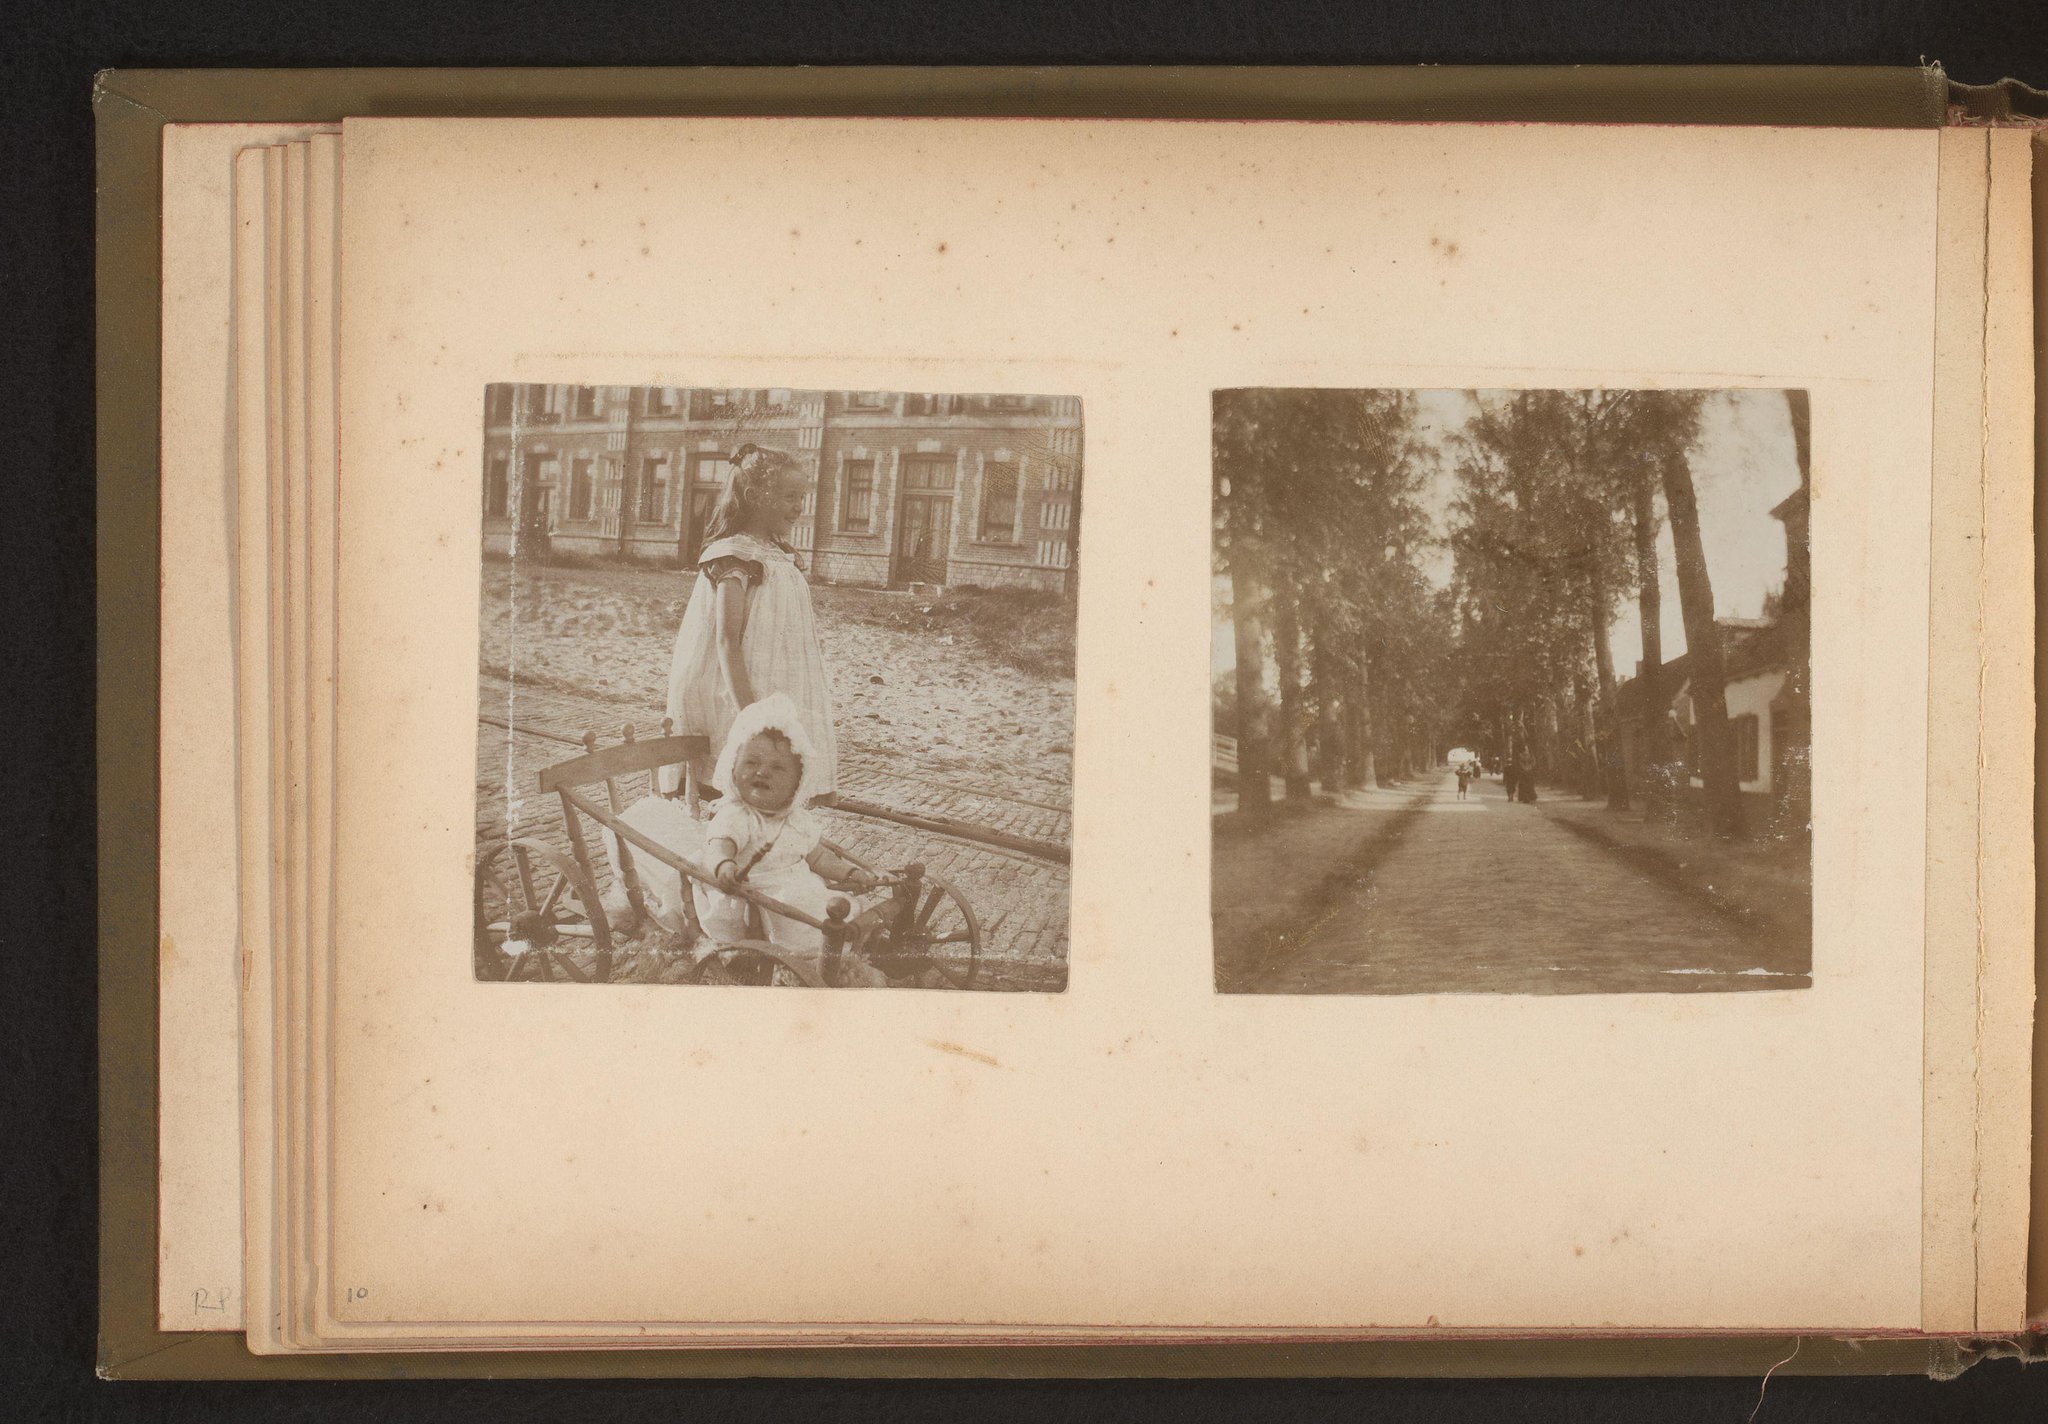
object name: album leaf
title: Twee foto's van kinderen op straat en een laan met bomen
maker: Anonymous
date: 1895-1910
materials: paper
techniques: collodion silver print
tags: infant, baby ~ the ages of man, public road, child between toddler and youth (of undetermined sex)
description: Deze foto's maken deel uit van een album.